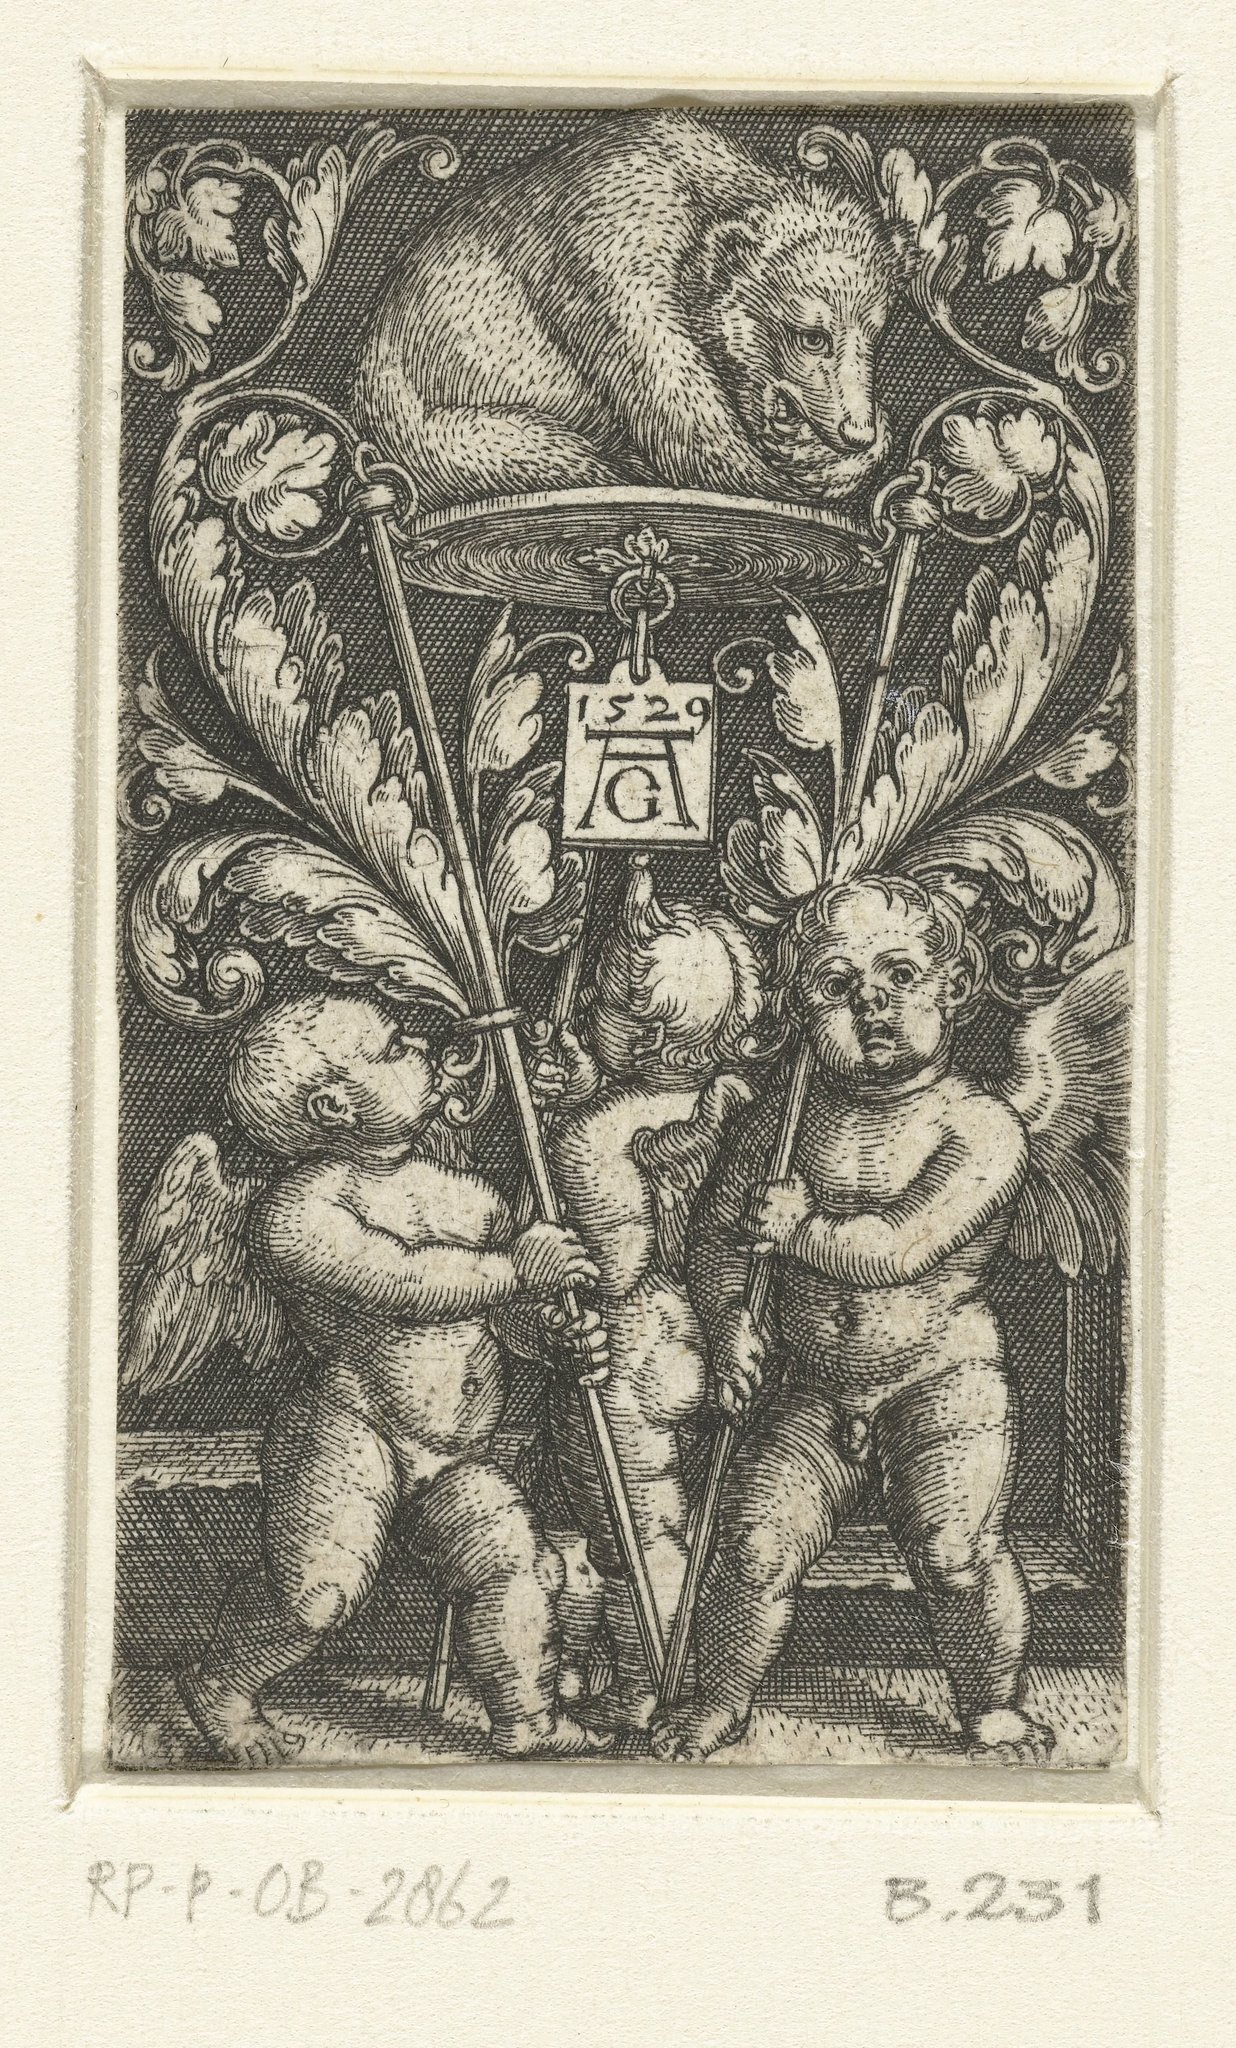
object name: print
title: Drie putti met een beer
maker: heinrich aldegrever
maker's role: draughtsman, print maker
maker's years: 1502-1561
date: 1529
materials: paper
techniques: engraving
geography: germany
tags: beasts of prey, predatory animals: bear, cupids: 'amores', 'amoretti', 'putti'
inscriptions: number: ‘22’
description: Vlakdecoratie met drie putti die met stokken een schild omhoog houden. Op het schild ligt een beer.